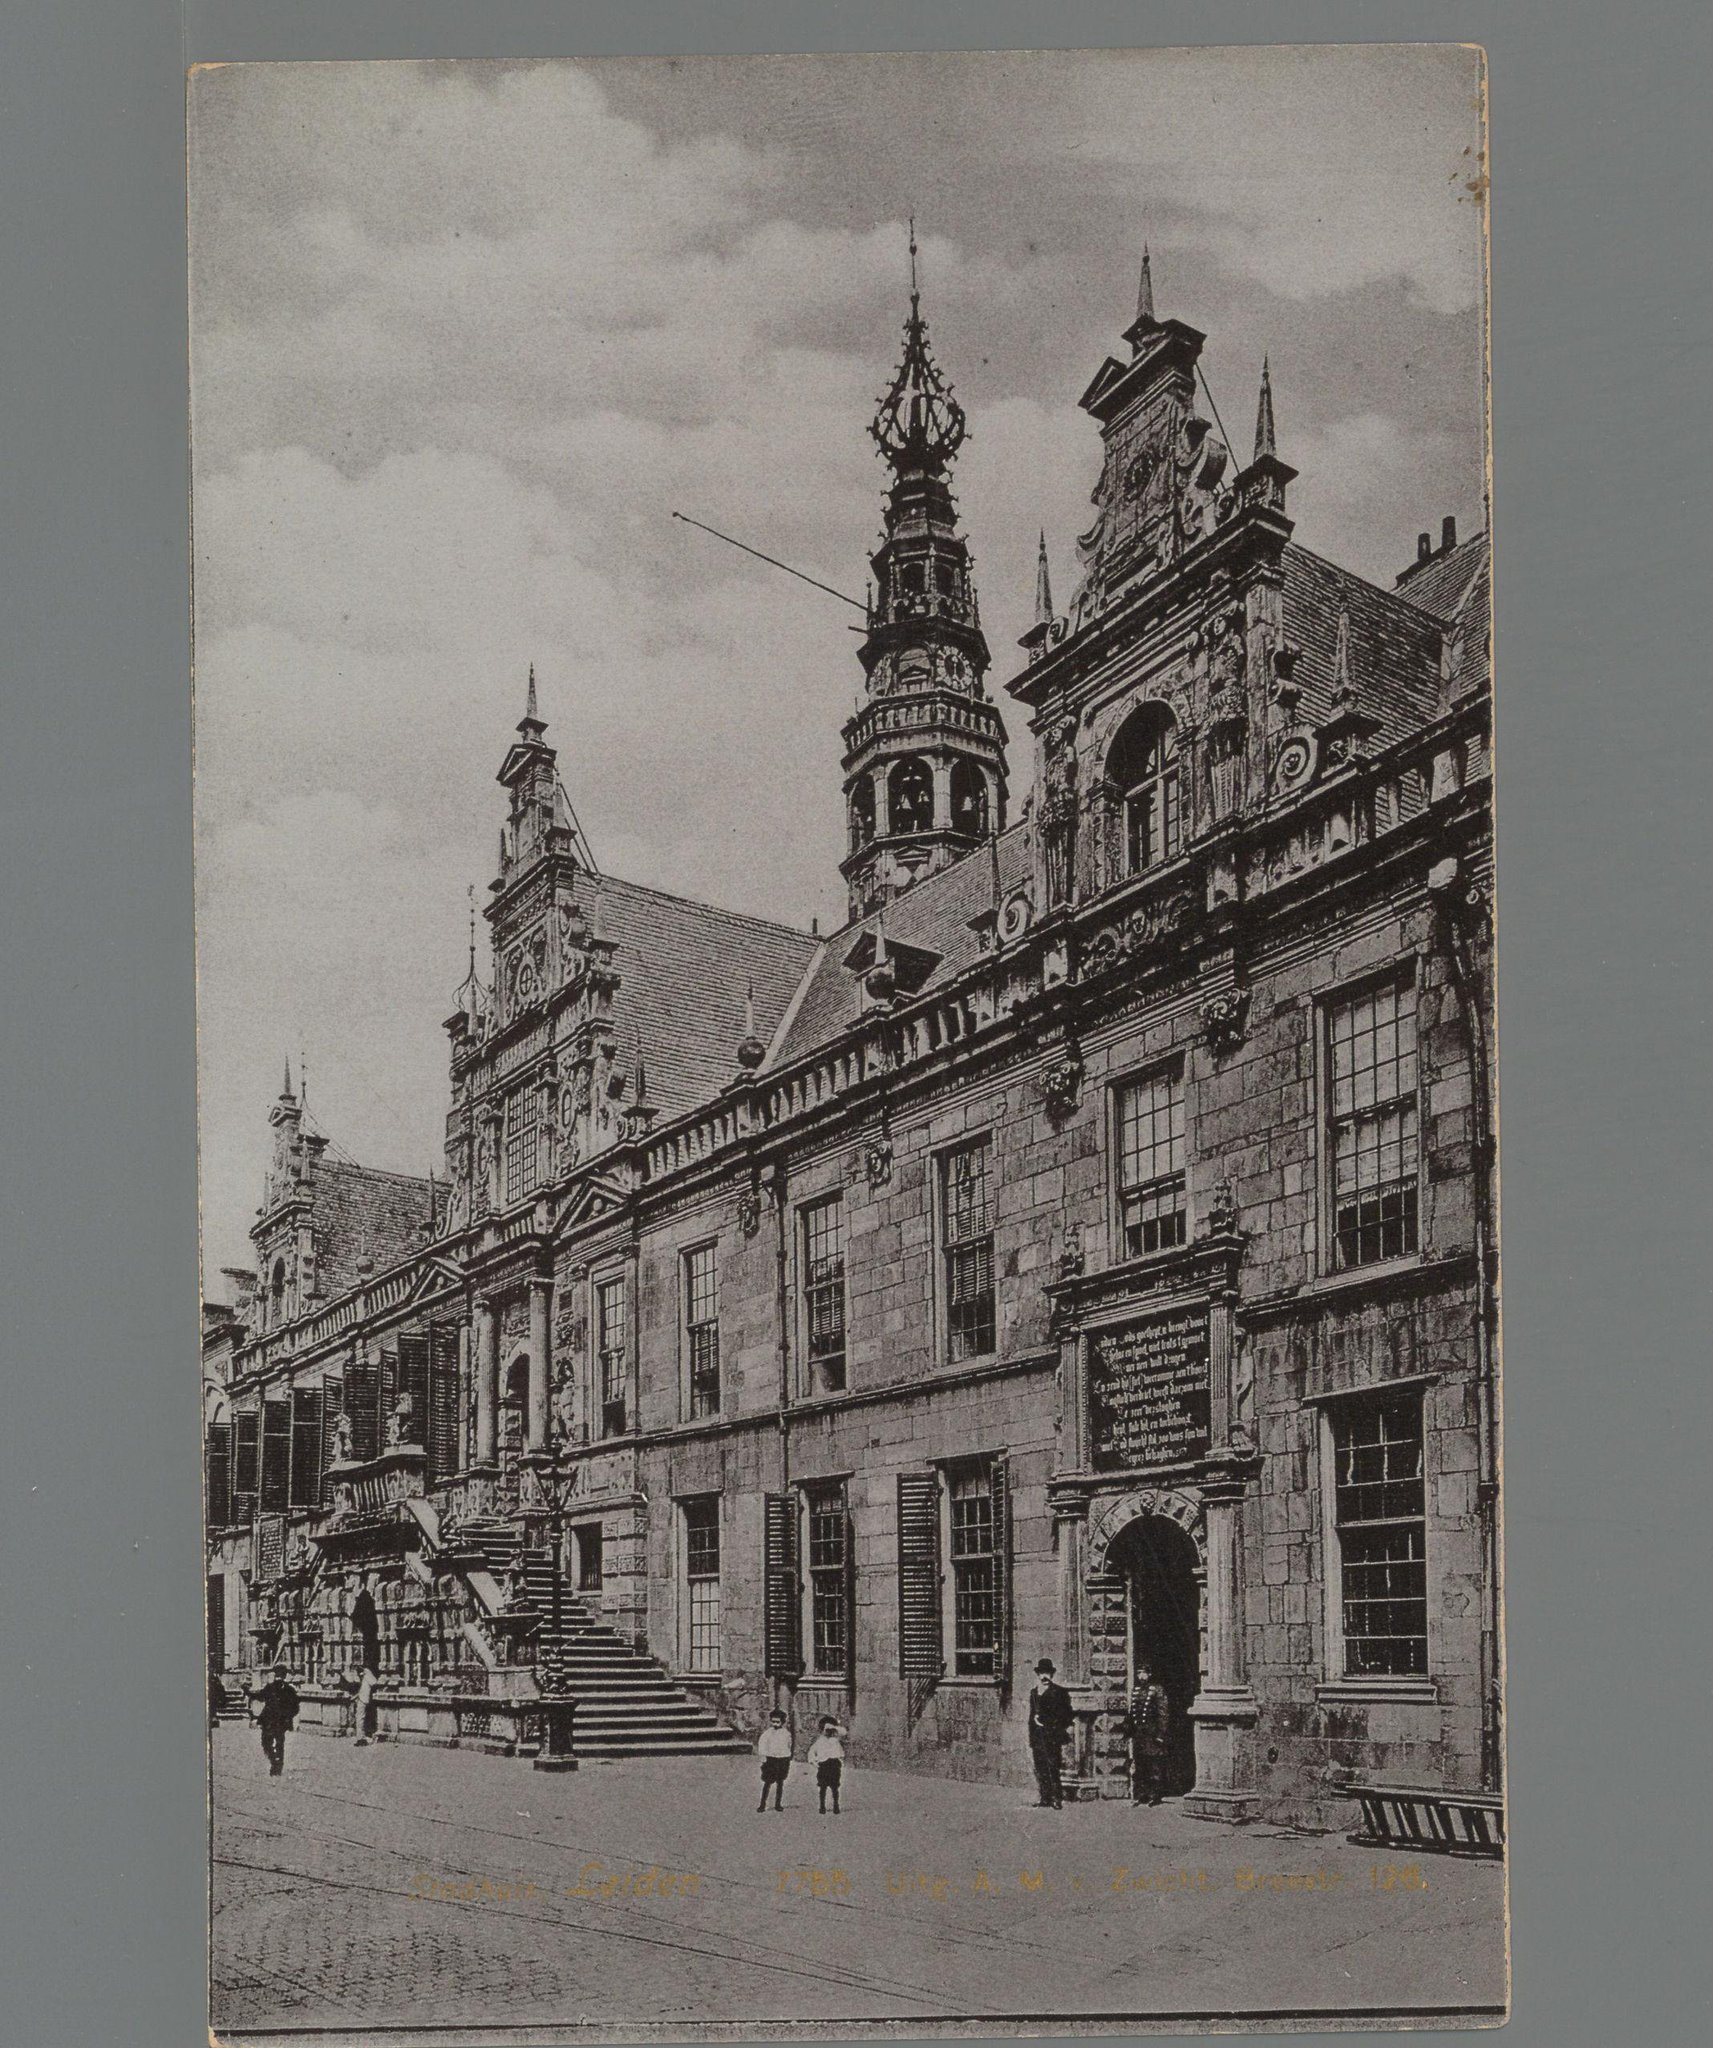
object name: photomechanical print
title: Sadhuis, Leiden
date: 1903-1905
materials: cardboard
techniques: photograph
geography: leiden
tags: townhall